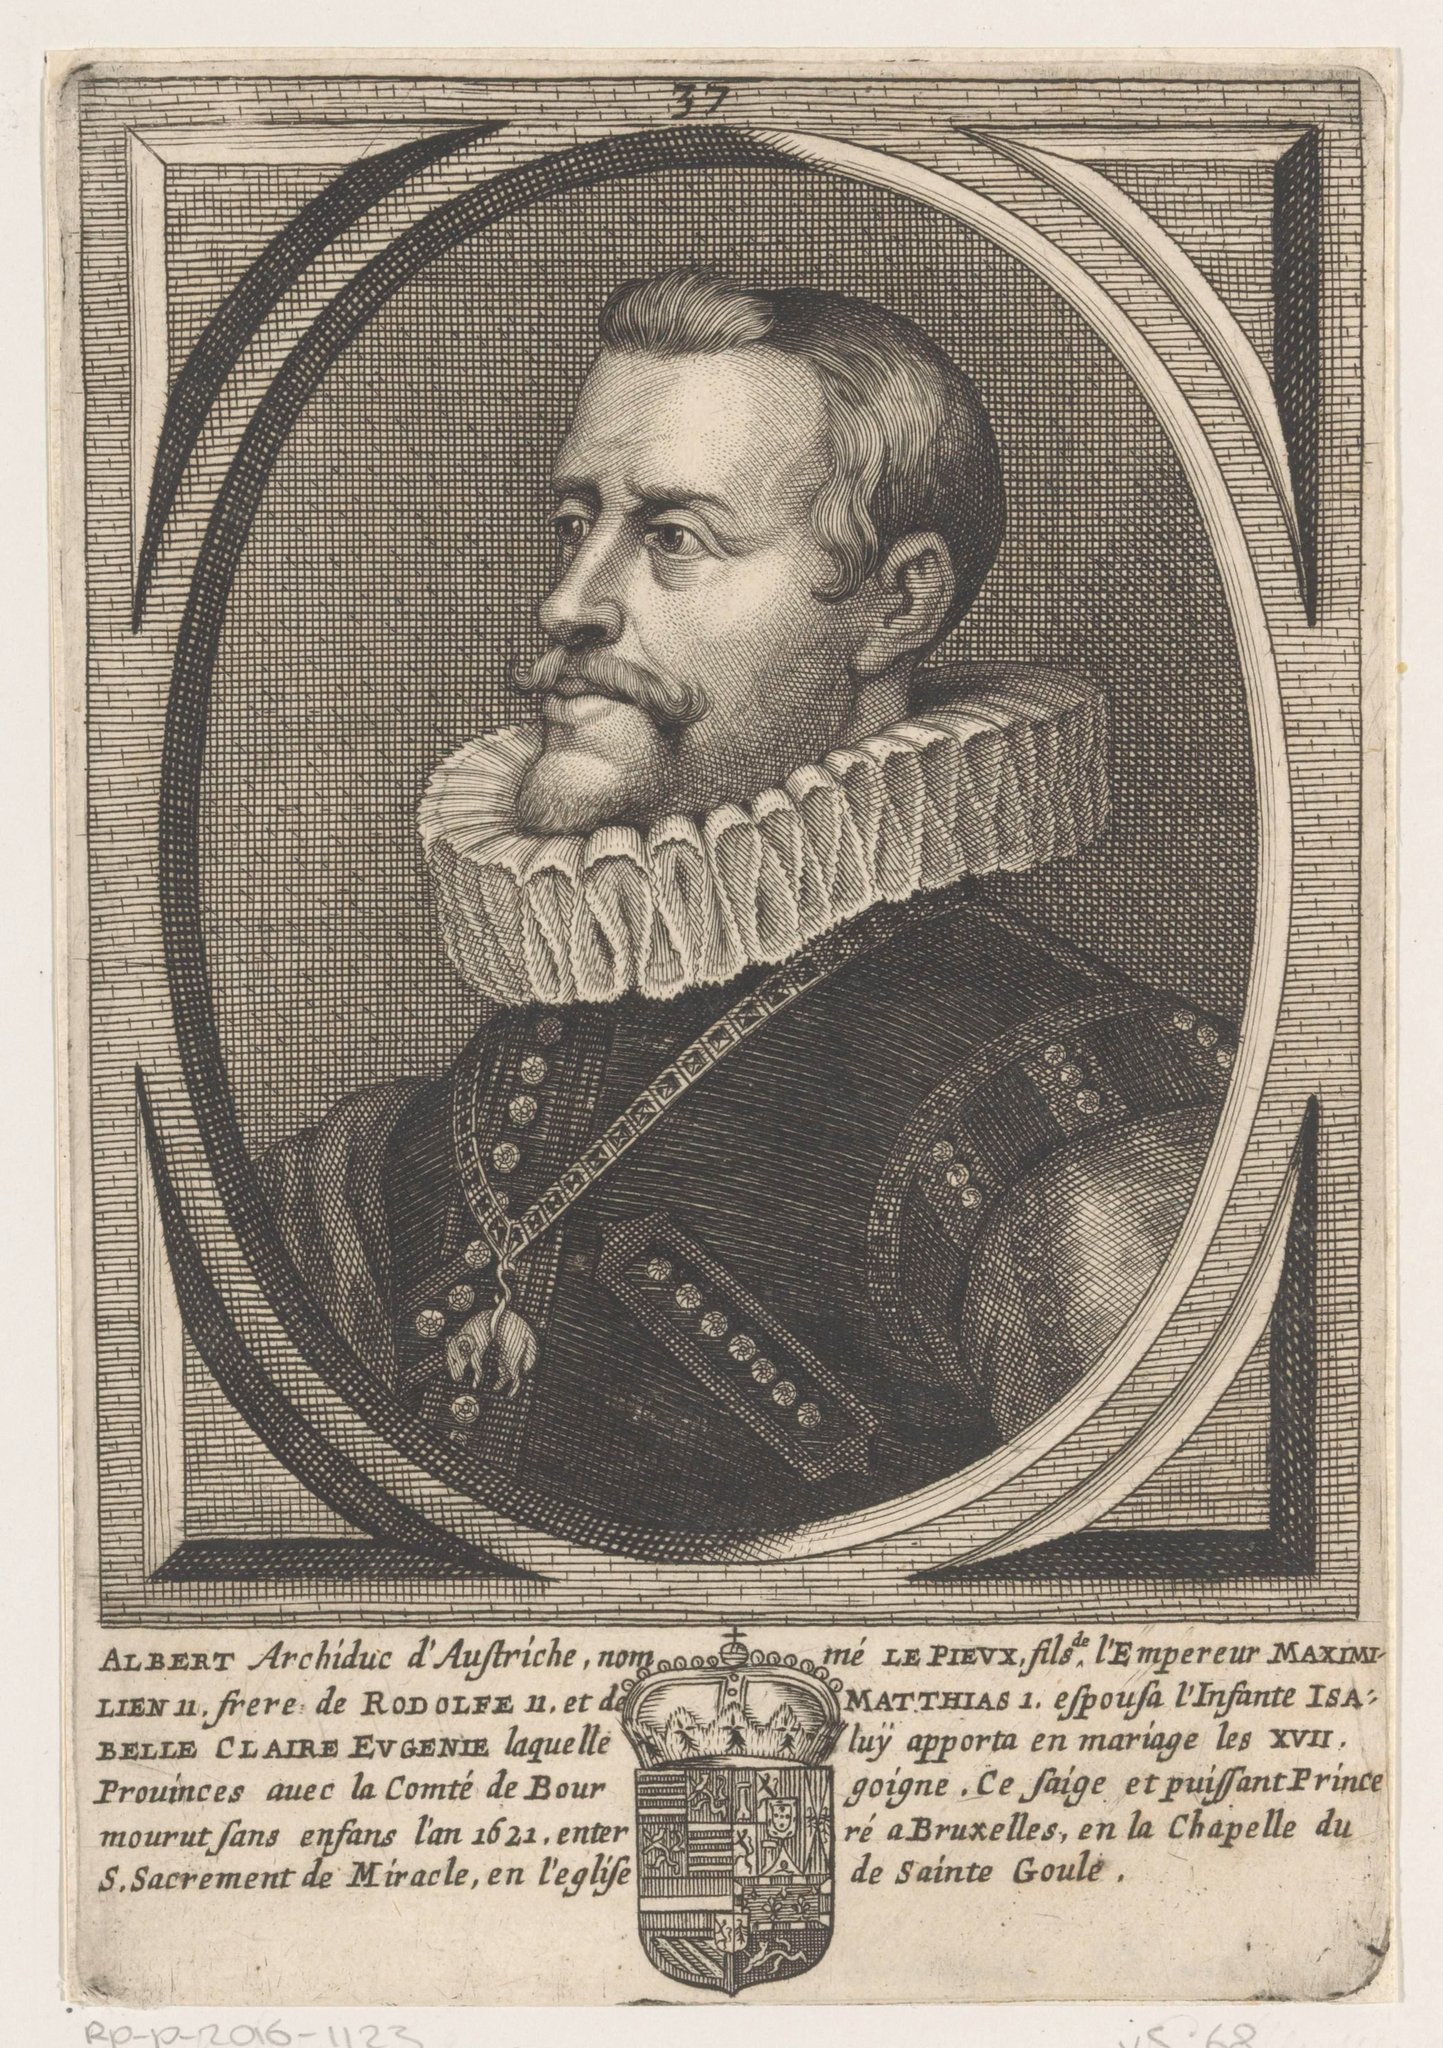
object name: print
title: Portret van Albrecht, aartshertog van Oostenrijk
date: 1662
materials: paper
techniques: engraving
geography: antwerp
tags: brussels, albrecht aartshertog van oostenrijk, knighthood order of the golden fleece - insignia of a knighthood order, e.g.: badge, chain (with name of order)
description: Prent uit: Meyssens, Joannes. Les portraits des souvereins, princes et comtes de Hollande par Jean Meyssens, peintre et gravez par son fils Cornille Meyssens l'an 1662. Antwerpen: Joannes Meyssens, 1662.